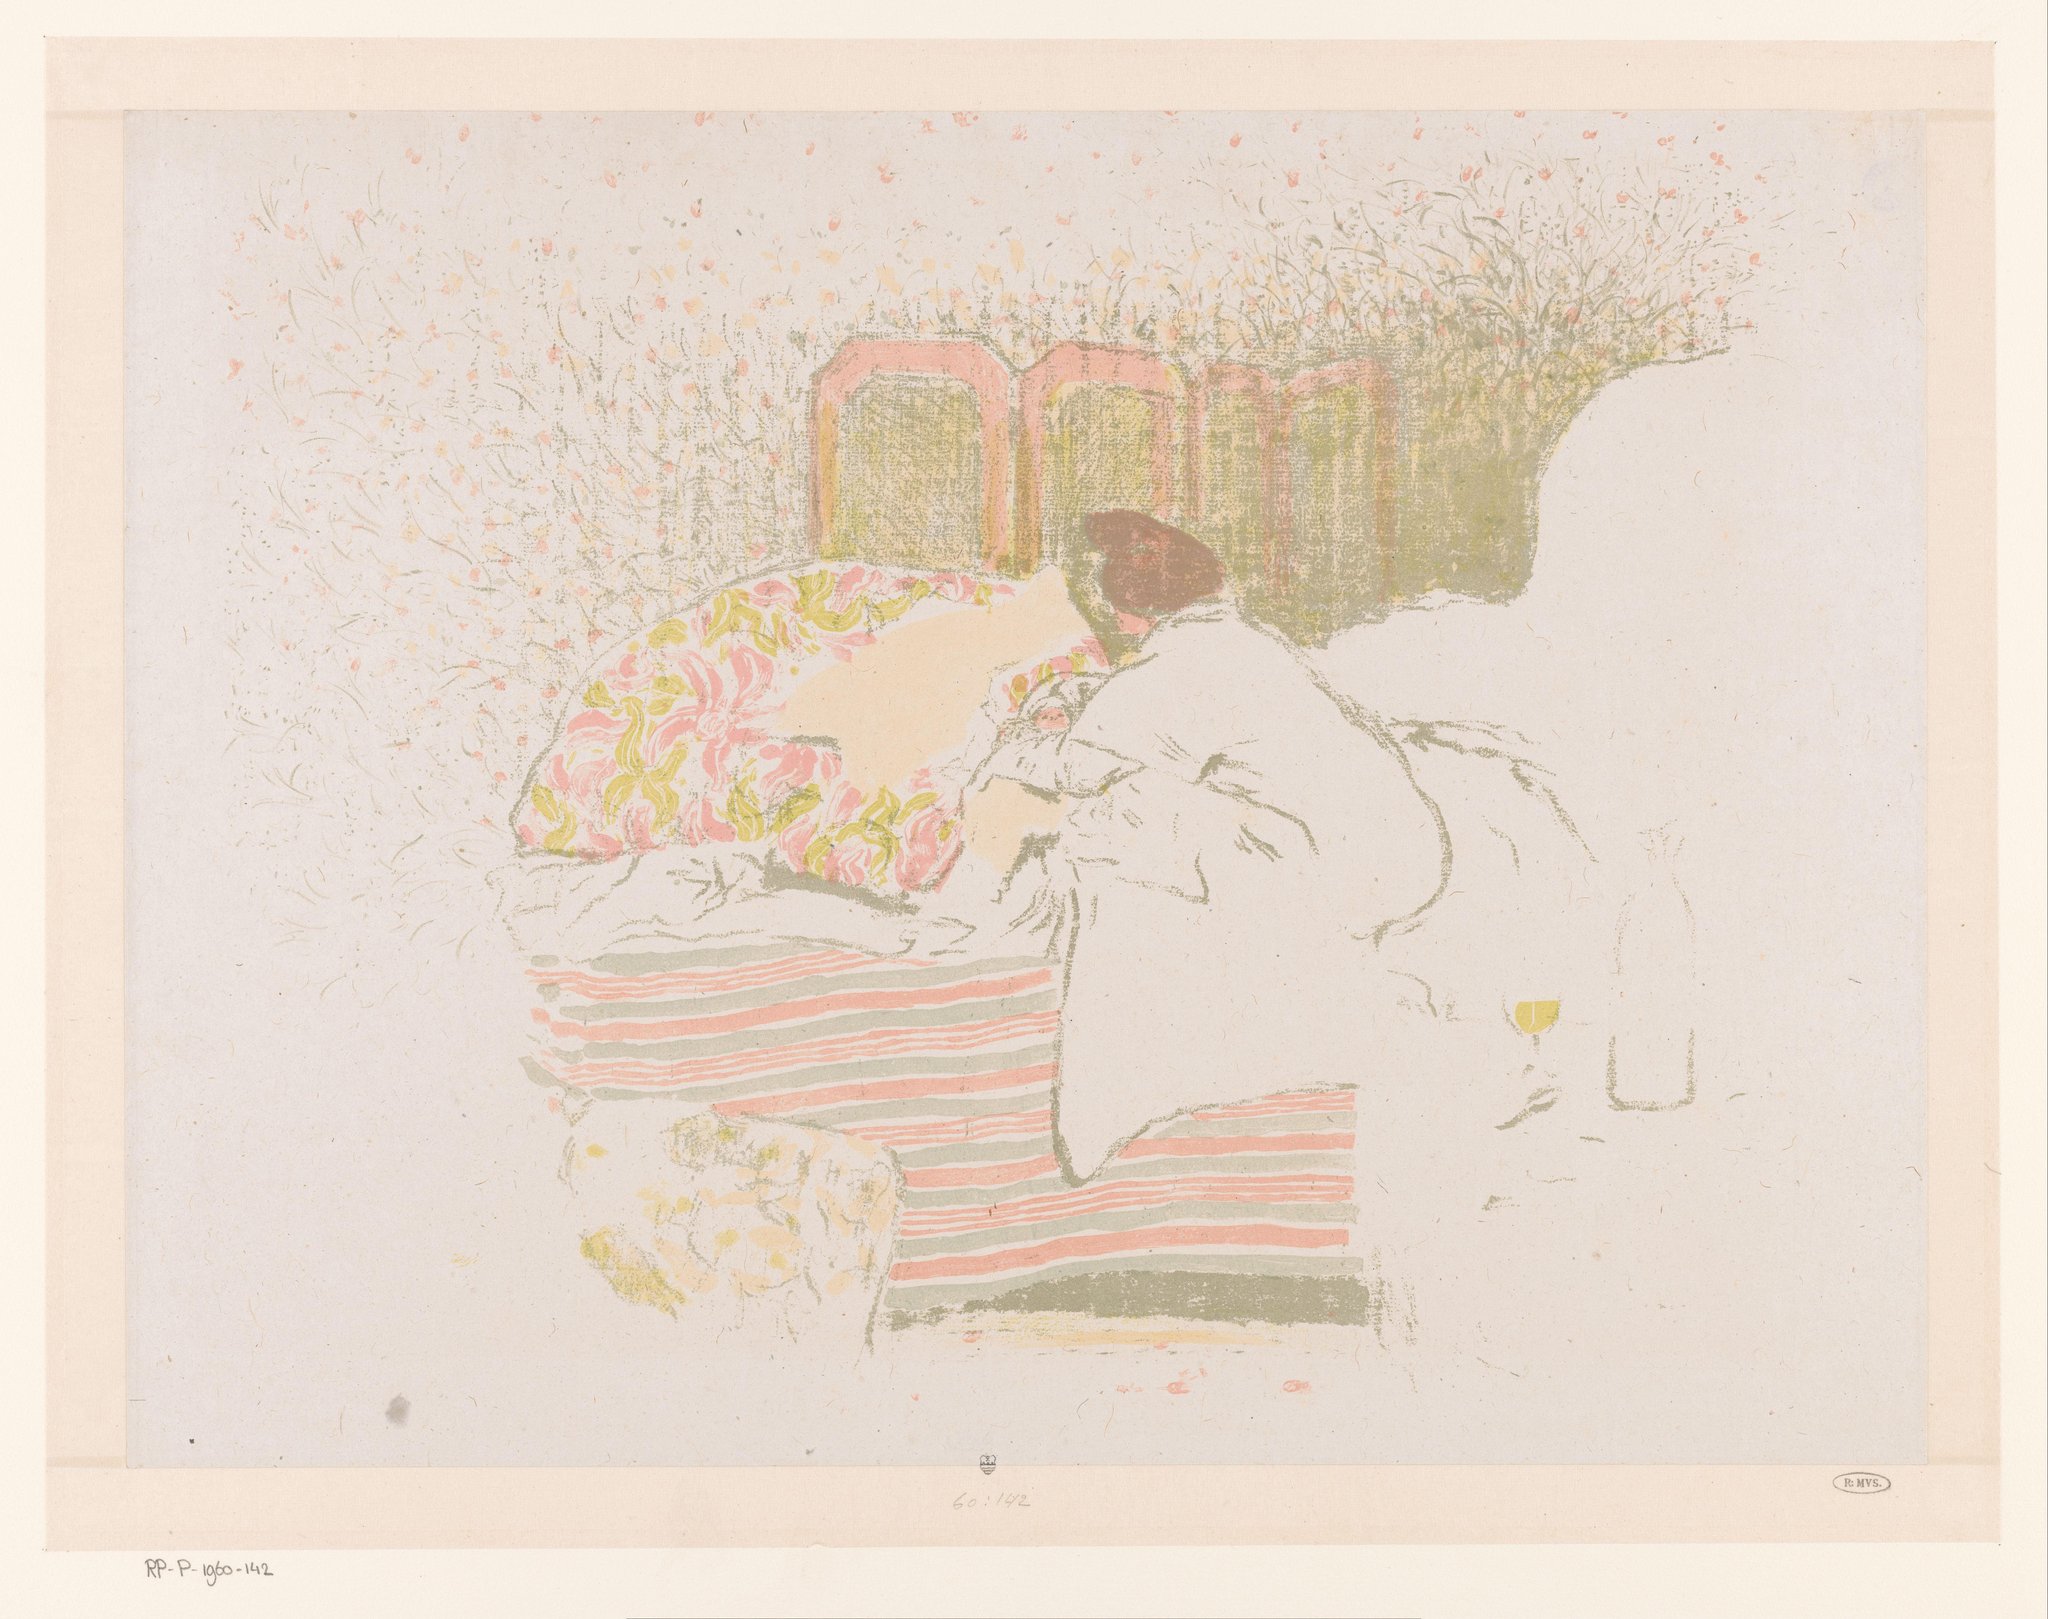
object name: print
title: La naissance d'Annette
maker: édouard vuillard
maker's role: draughtsman, print maker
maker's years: 1868-1940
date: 1899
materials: paper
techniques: lithograph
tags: bed, mother and baby or young child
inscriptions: collector's mark: Lugt 2228, collector's mark: Lugt 2760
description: Prent gemaakt voor: L'Album d'estampes originales de la Galerie Vollard, vol. 2, ongepubliceerd.